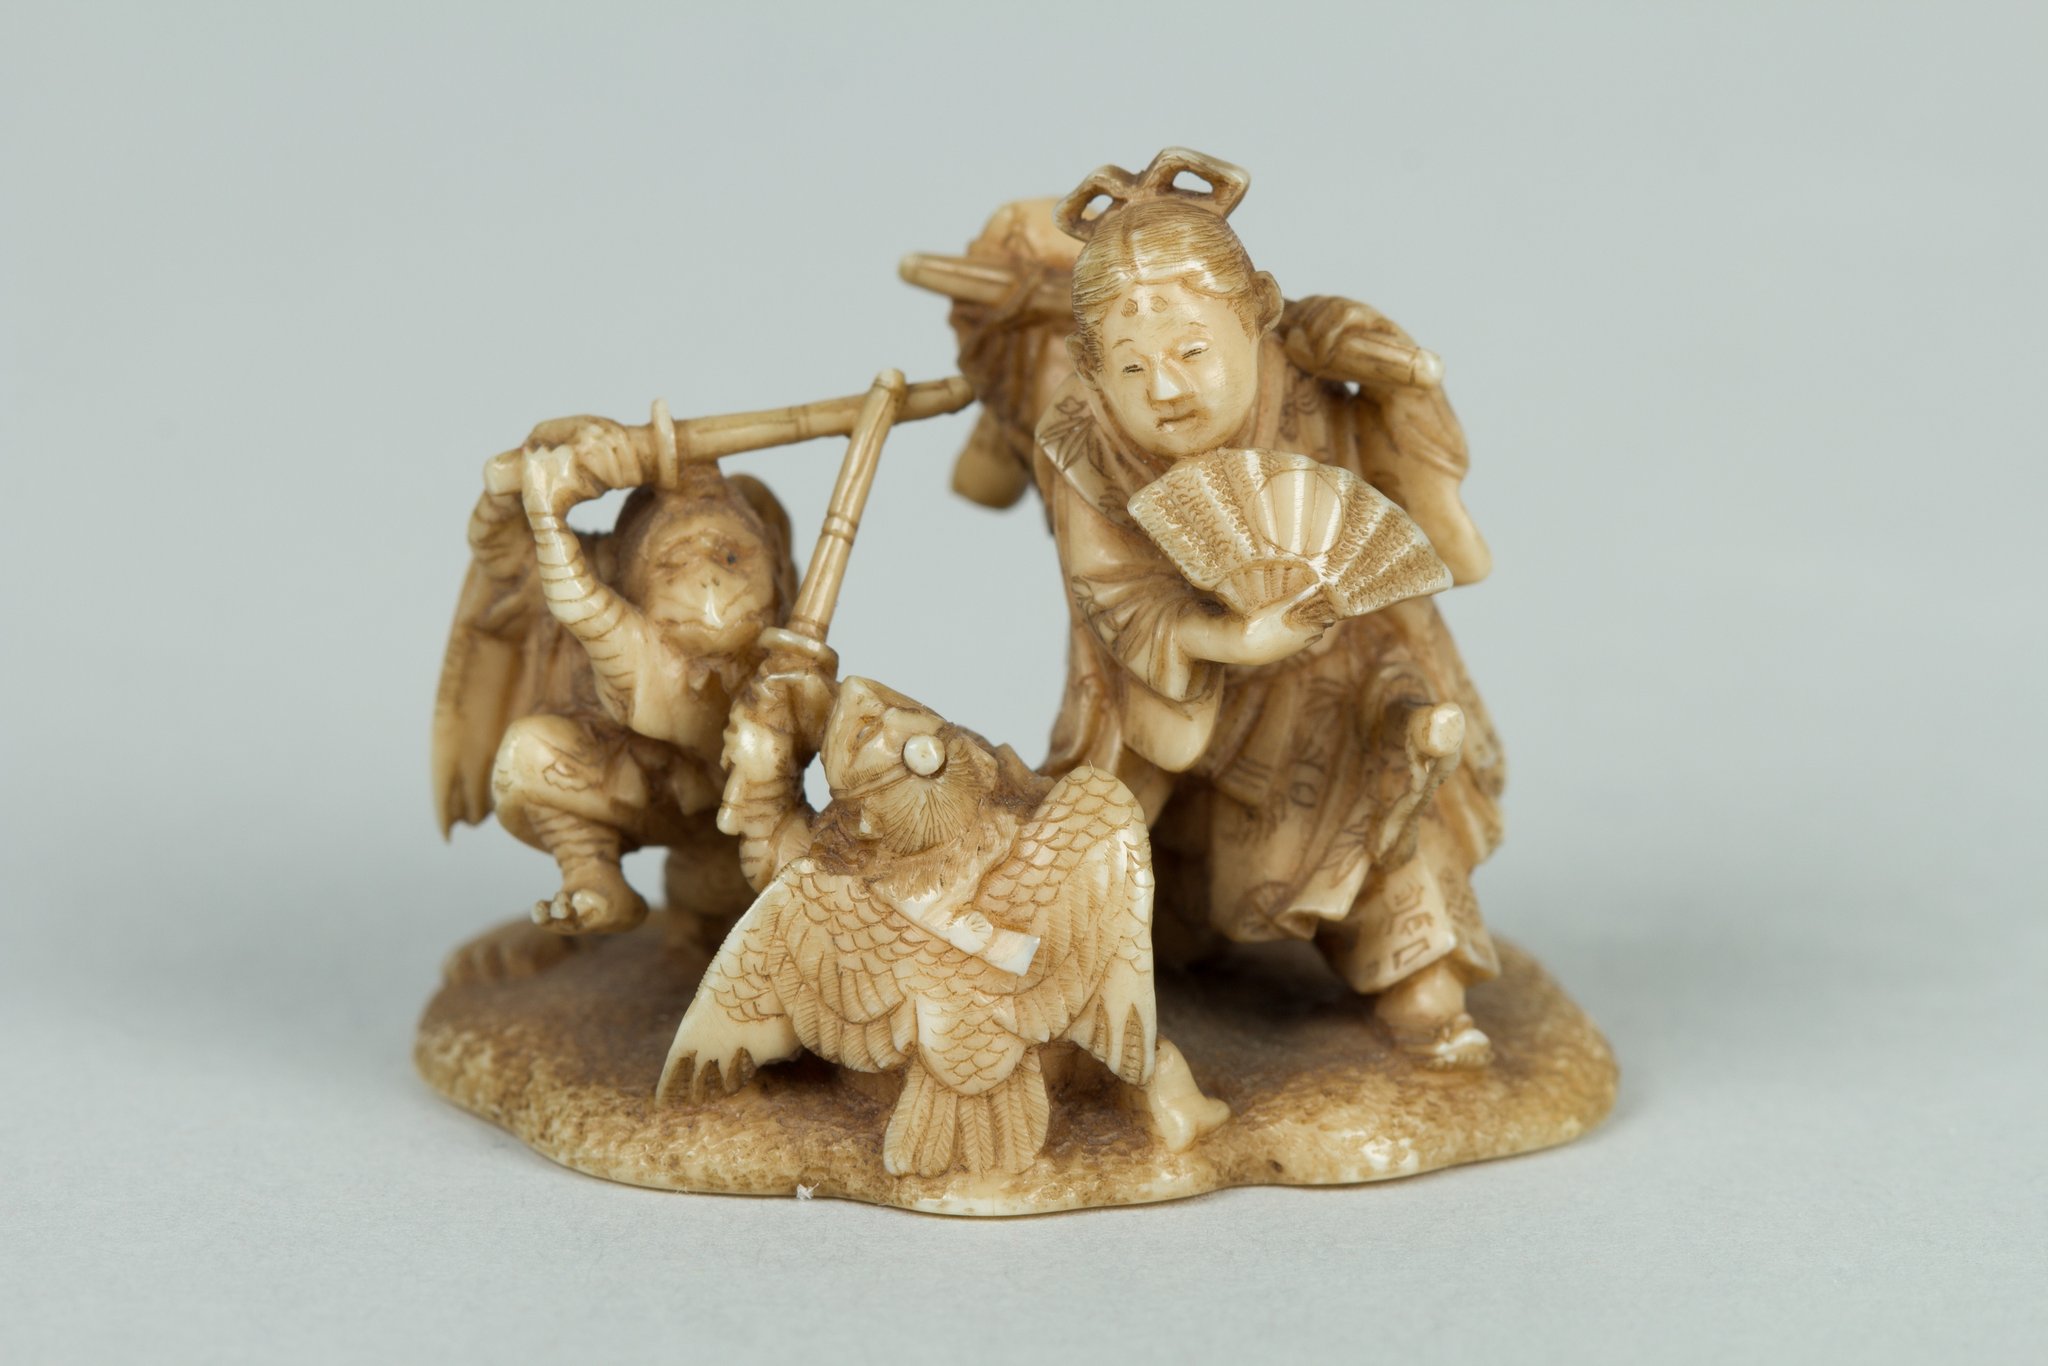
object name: netsuke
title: Netsuke: Group of Figures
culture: japanese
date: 1801-1900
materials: ivory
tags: human figures,monkeys